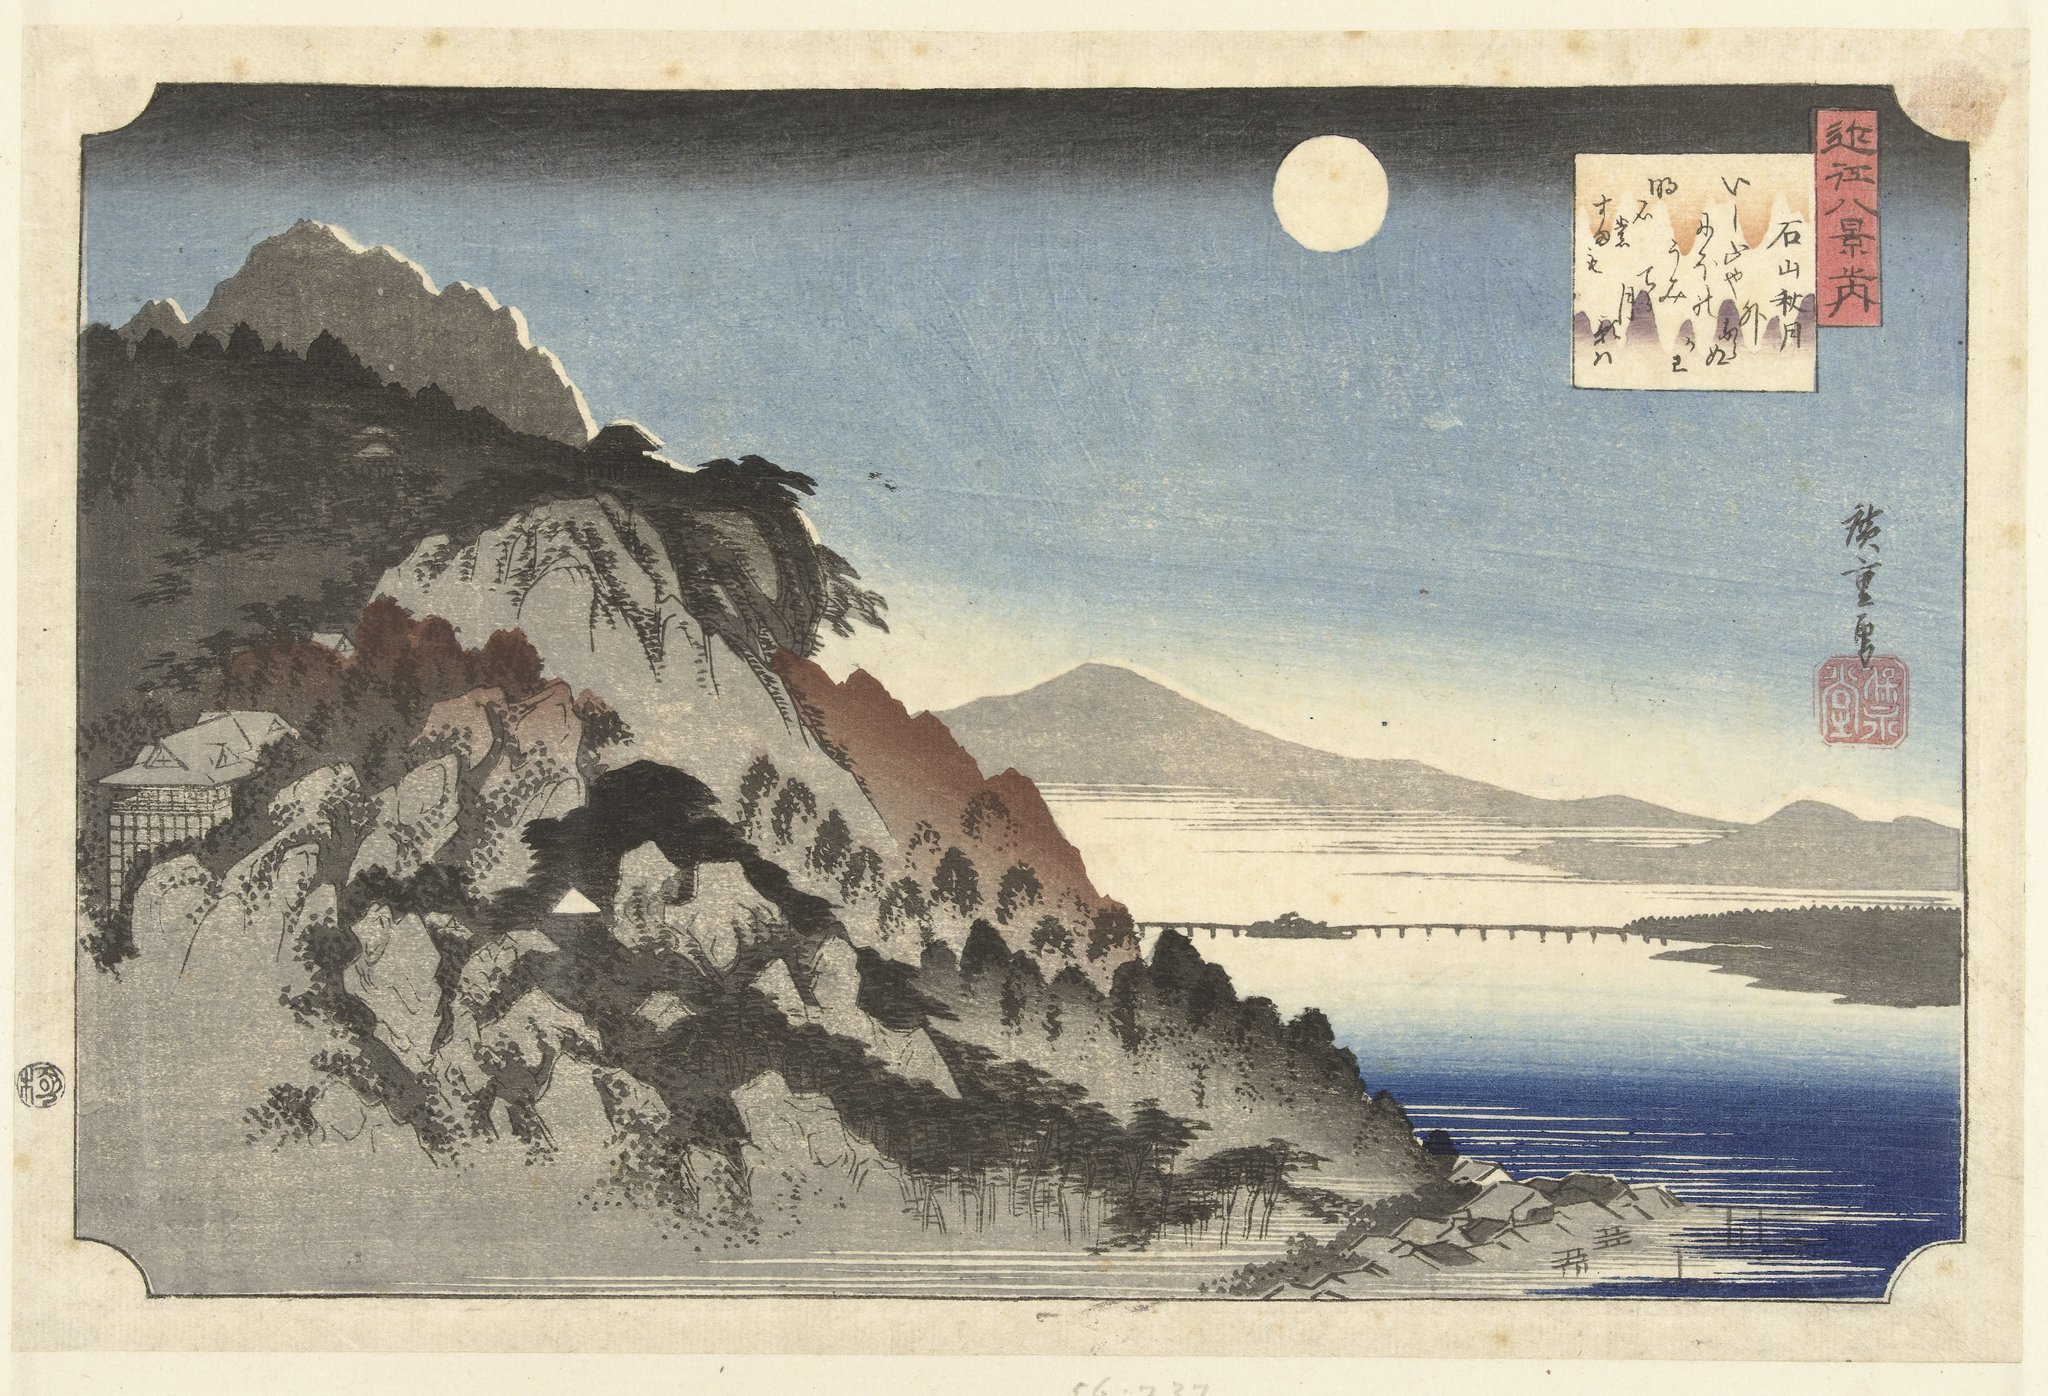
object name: print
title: Acht gezichten op de provincie Omi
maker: utagawa hiroshige (i)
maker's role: draughtsman, print maker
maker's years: 1797-1858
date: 1833-1837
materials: paper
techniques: woodcut, nishiki e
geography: japan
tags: full moon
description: Berglandschap met uiterst links, tegen de bergwand, de Ishiyama tempel en op de achtergrond het Biwa meer met de Seta brug; bij volle maan. In het vierkante cartouche rechtsboven een gedicht.